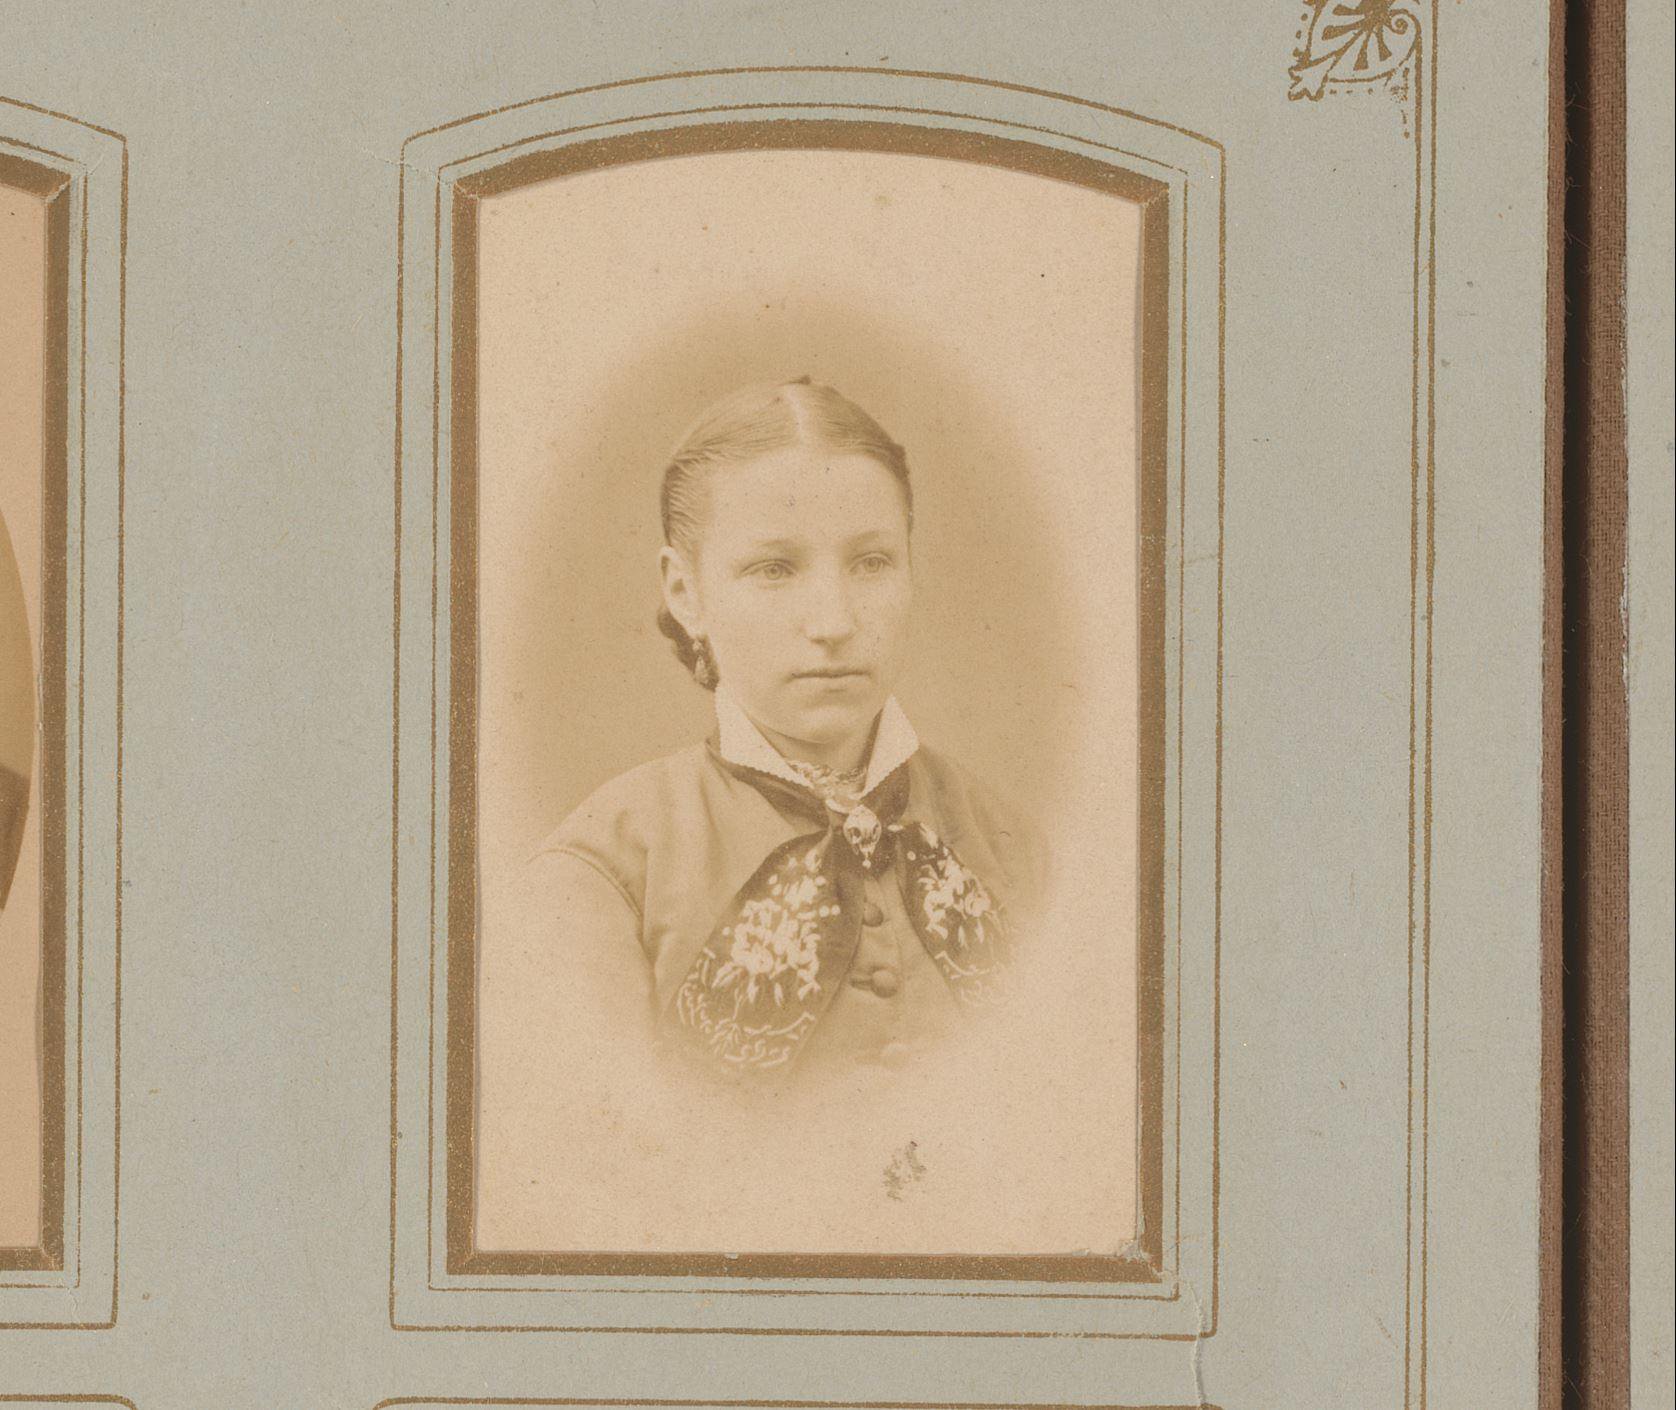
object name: photograph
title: Portret van een jonge vrouw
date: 1857-1894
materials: cardboard, photographic support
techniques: albumen print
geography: edam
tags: adolescent, young woman, maiden, historical persons - bb - woman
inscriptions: inscription: ‘P. SIEWERS en ZOON/ Photograph/ ATELIER/ EDAM/ Voorhaven/ HILVERSUM/ Badhuis./ Te Edam dagelyks werkzaam./ Te Hilversum Zondags en maandags./ De Plaats wordt voor Nabestelling/ bewaard.’